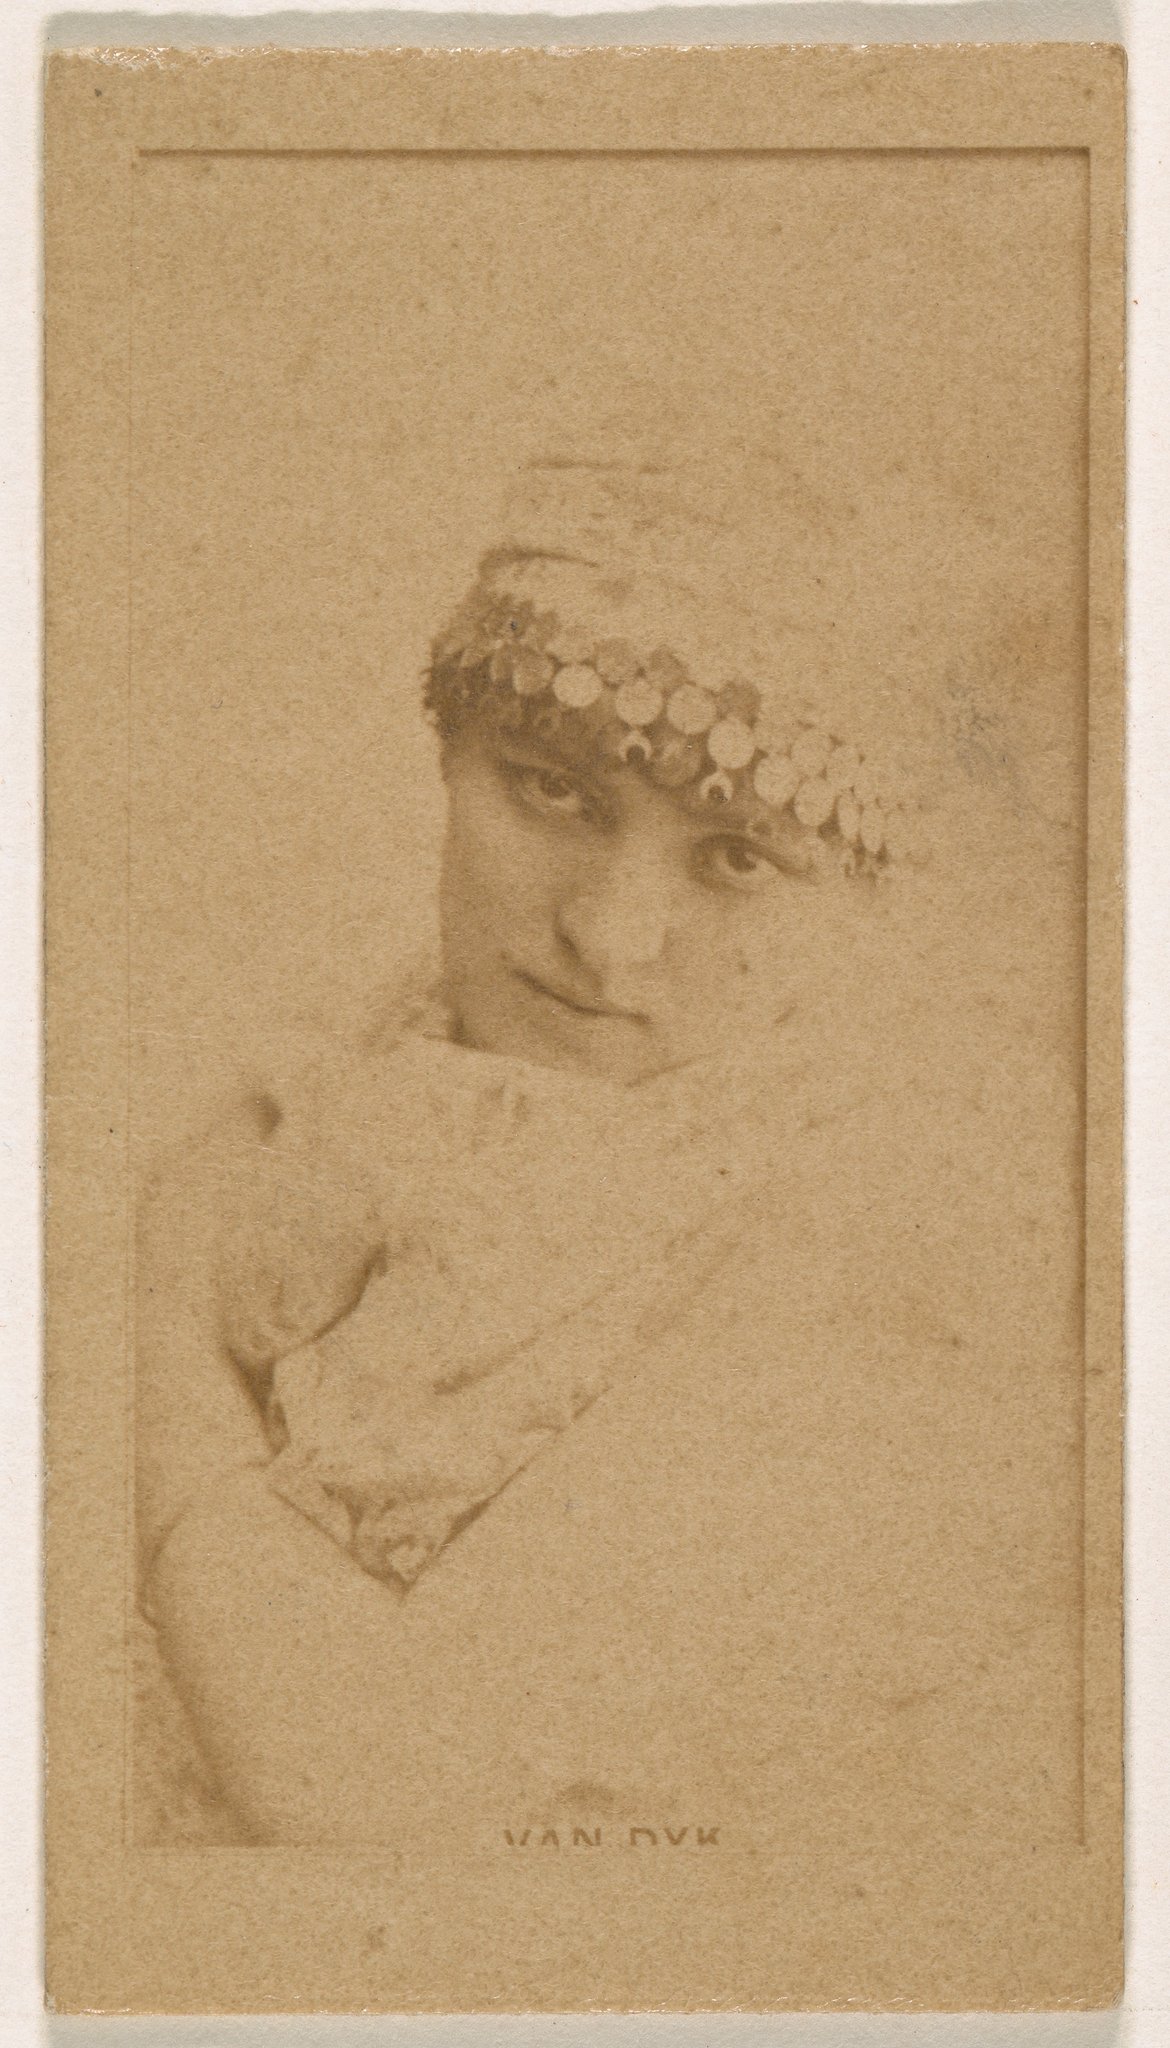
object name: photograph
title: Miss Van Dyk, from the Actresses series (N245) issued by Kinney Brothers to promote Sweet Caporal Cigarettes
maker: kinney brothers tobacco company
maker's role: publisher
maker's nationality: american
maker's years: 1869-2011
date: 1890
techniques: albumen silver print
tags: portraits,women,actresses